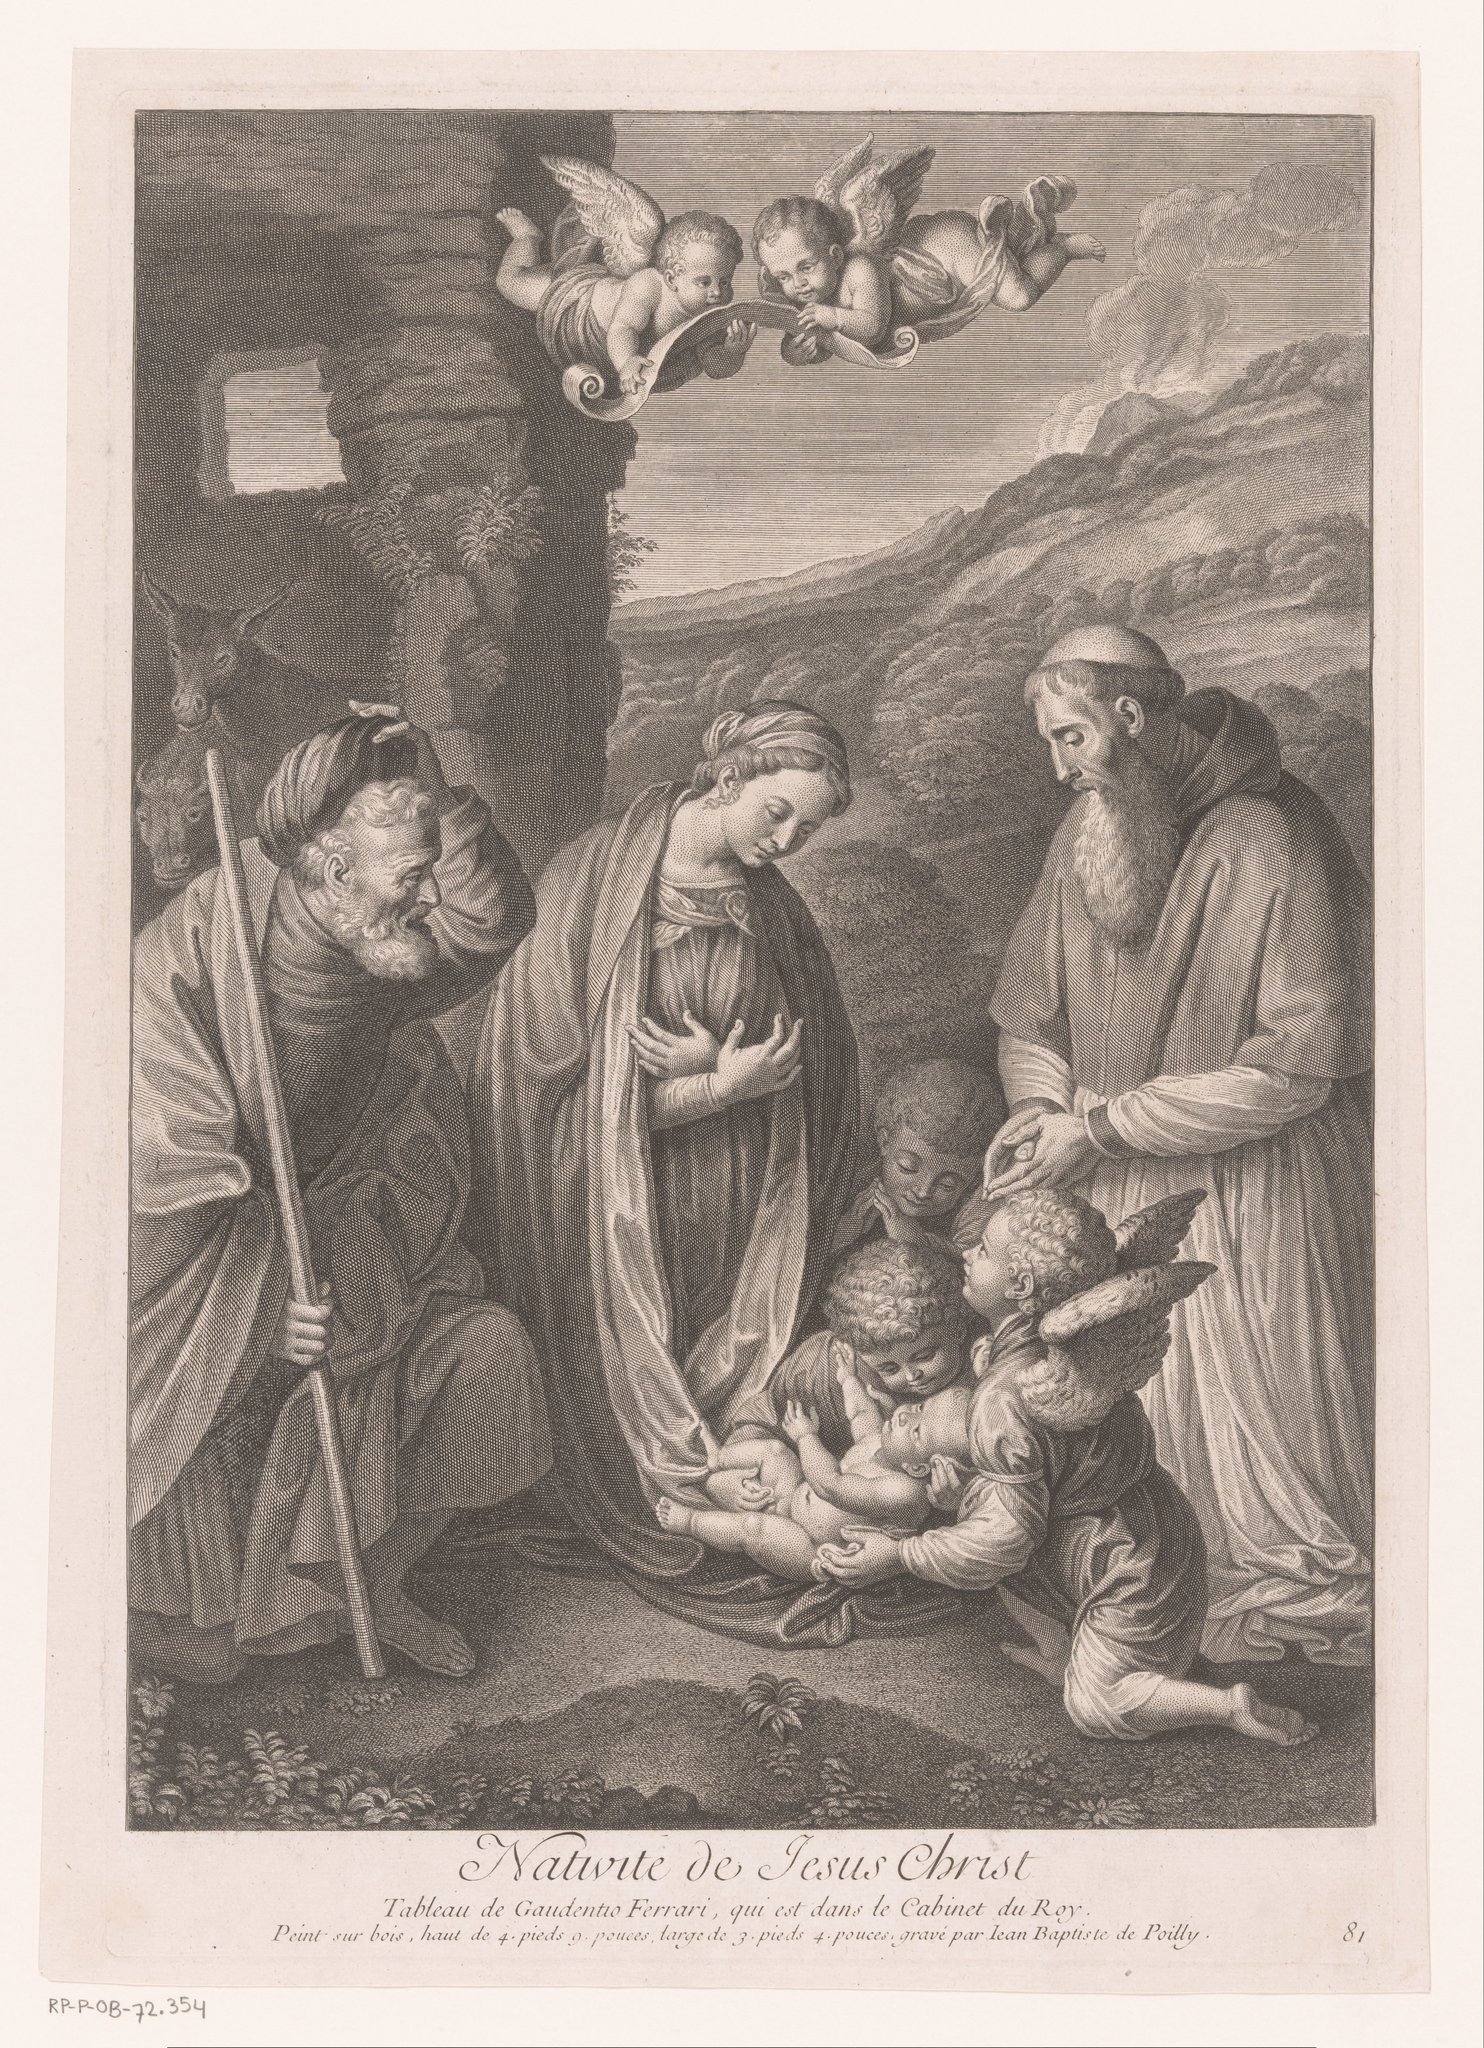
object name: print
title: Geboorte van Christus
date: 1709-1728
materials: paper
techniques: engraving, etching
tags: birth and youth of christ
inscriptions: collector's mark: Lugt 2228